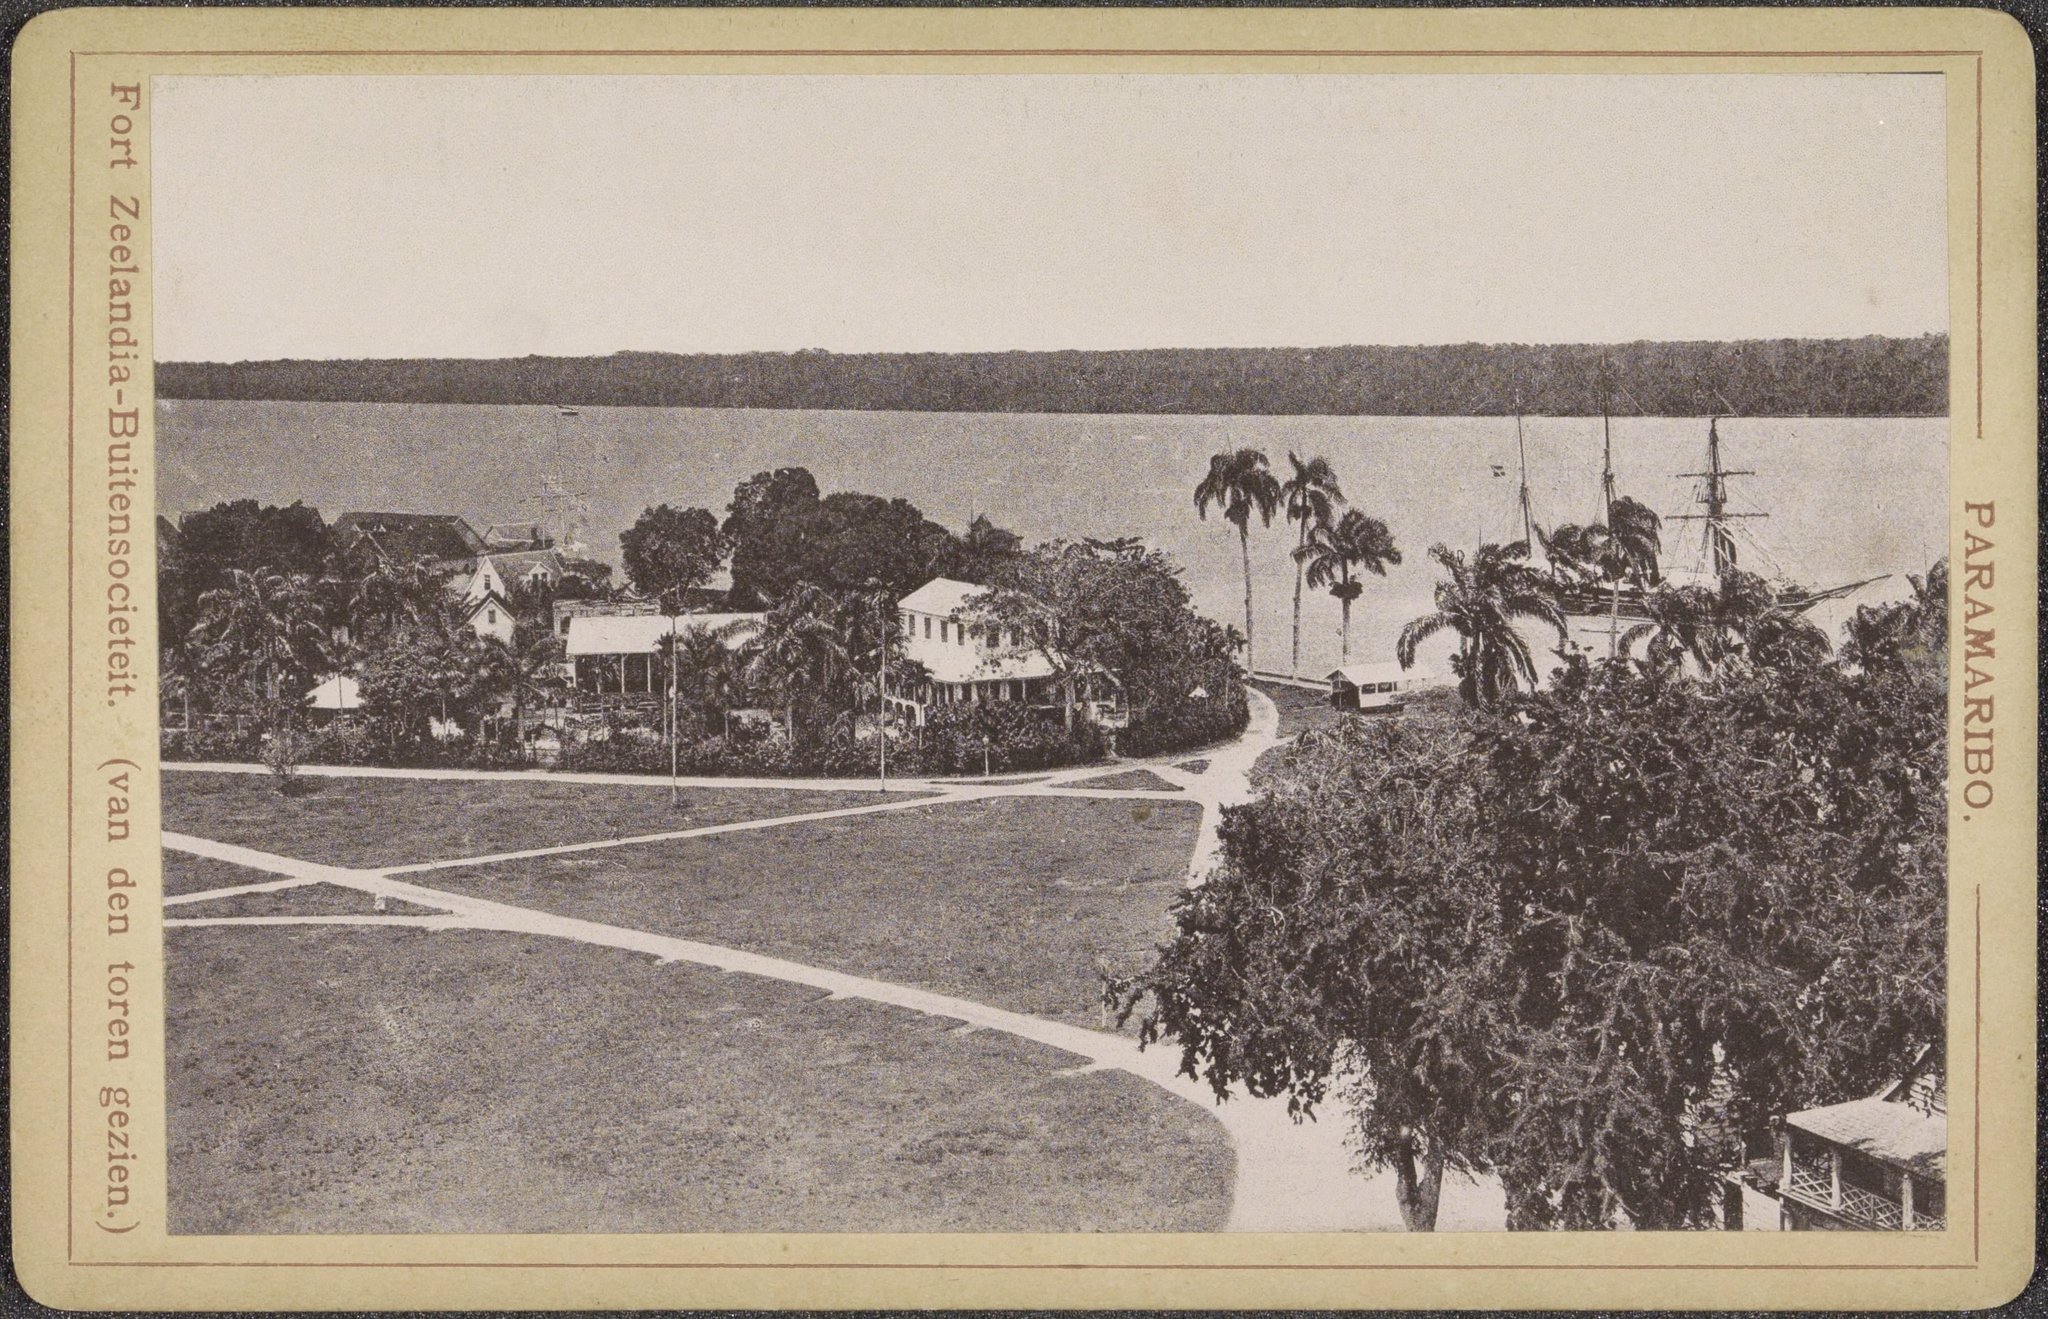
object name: cabinet photograph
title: Fort Zeelandia en de Buitensociëteit in Paramaribo gezien vanaf een toren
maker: eugen klein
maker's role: fotograaf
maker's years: 1869-1927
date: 1900-1927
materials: cardboard, paper, ink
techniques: photograph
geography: paramaribo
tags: fortress, river, travelling; tourism, public gardens, park, prospect of city, town panorama, silhouette of city, suriname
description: Onderdeel van Fotoalbum met bezienswaardigheden in Paramaribo.